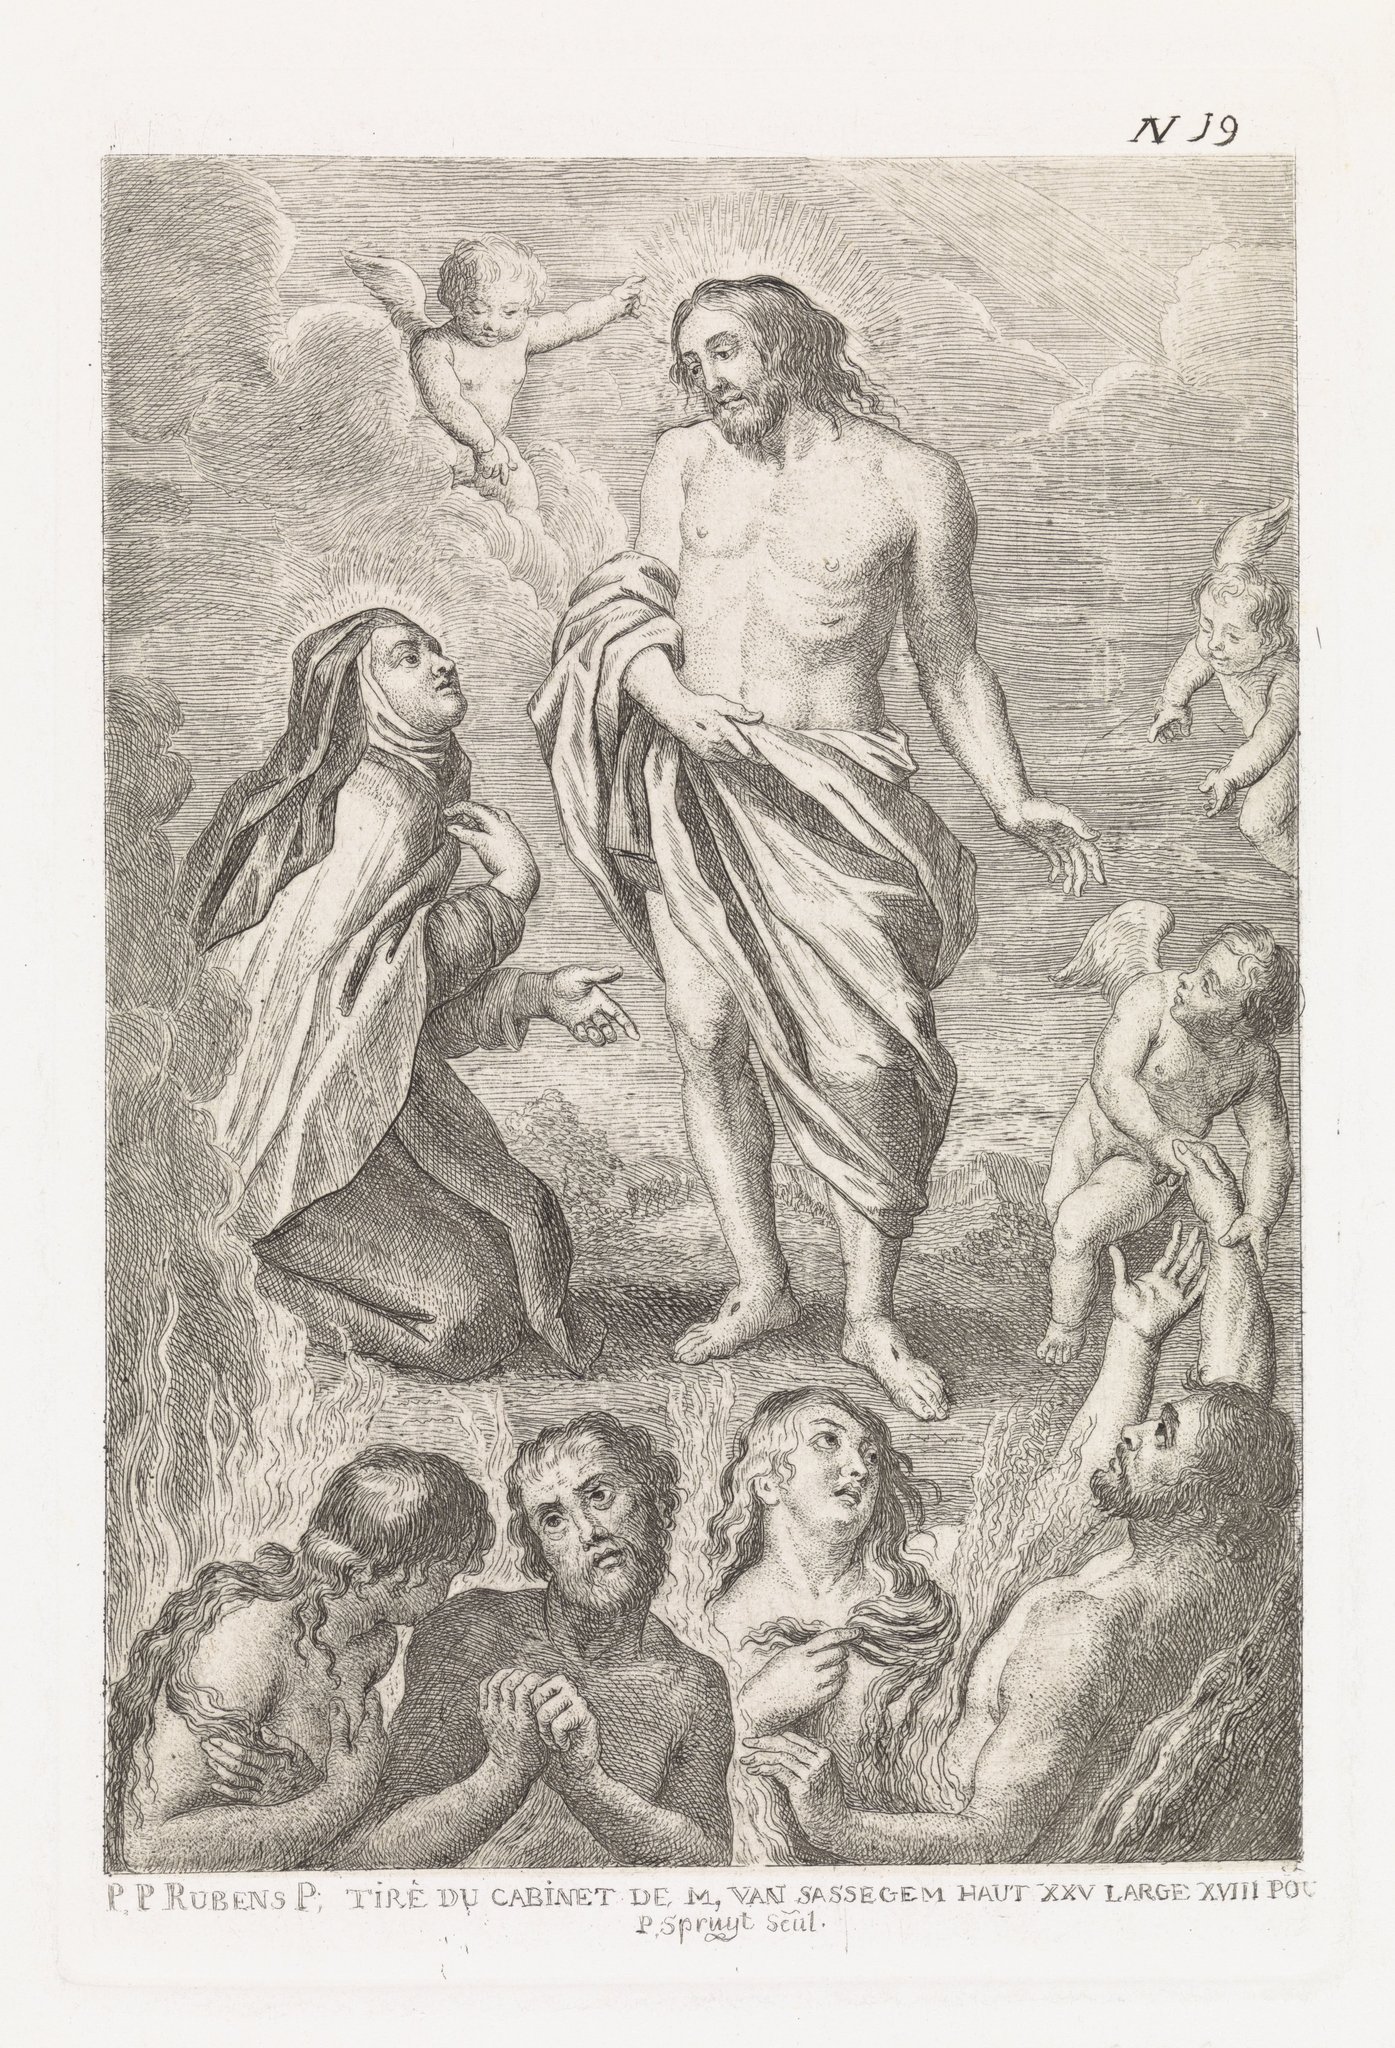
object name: print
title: Christus en de H. Teresa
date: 1747-1801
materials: paper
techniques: etching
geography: ghent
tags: st. theresa kneeling before christ, interceding for the souls in purgatory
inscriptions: collector's mark: Lugt 2228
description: De heilige Teresa van Avila doet voorspraak voor de mensen in het vagevuur bij Christus. Zij vraagt hem deze mensen te redden. Rechtsboven genummerd: N 19.